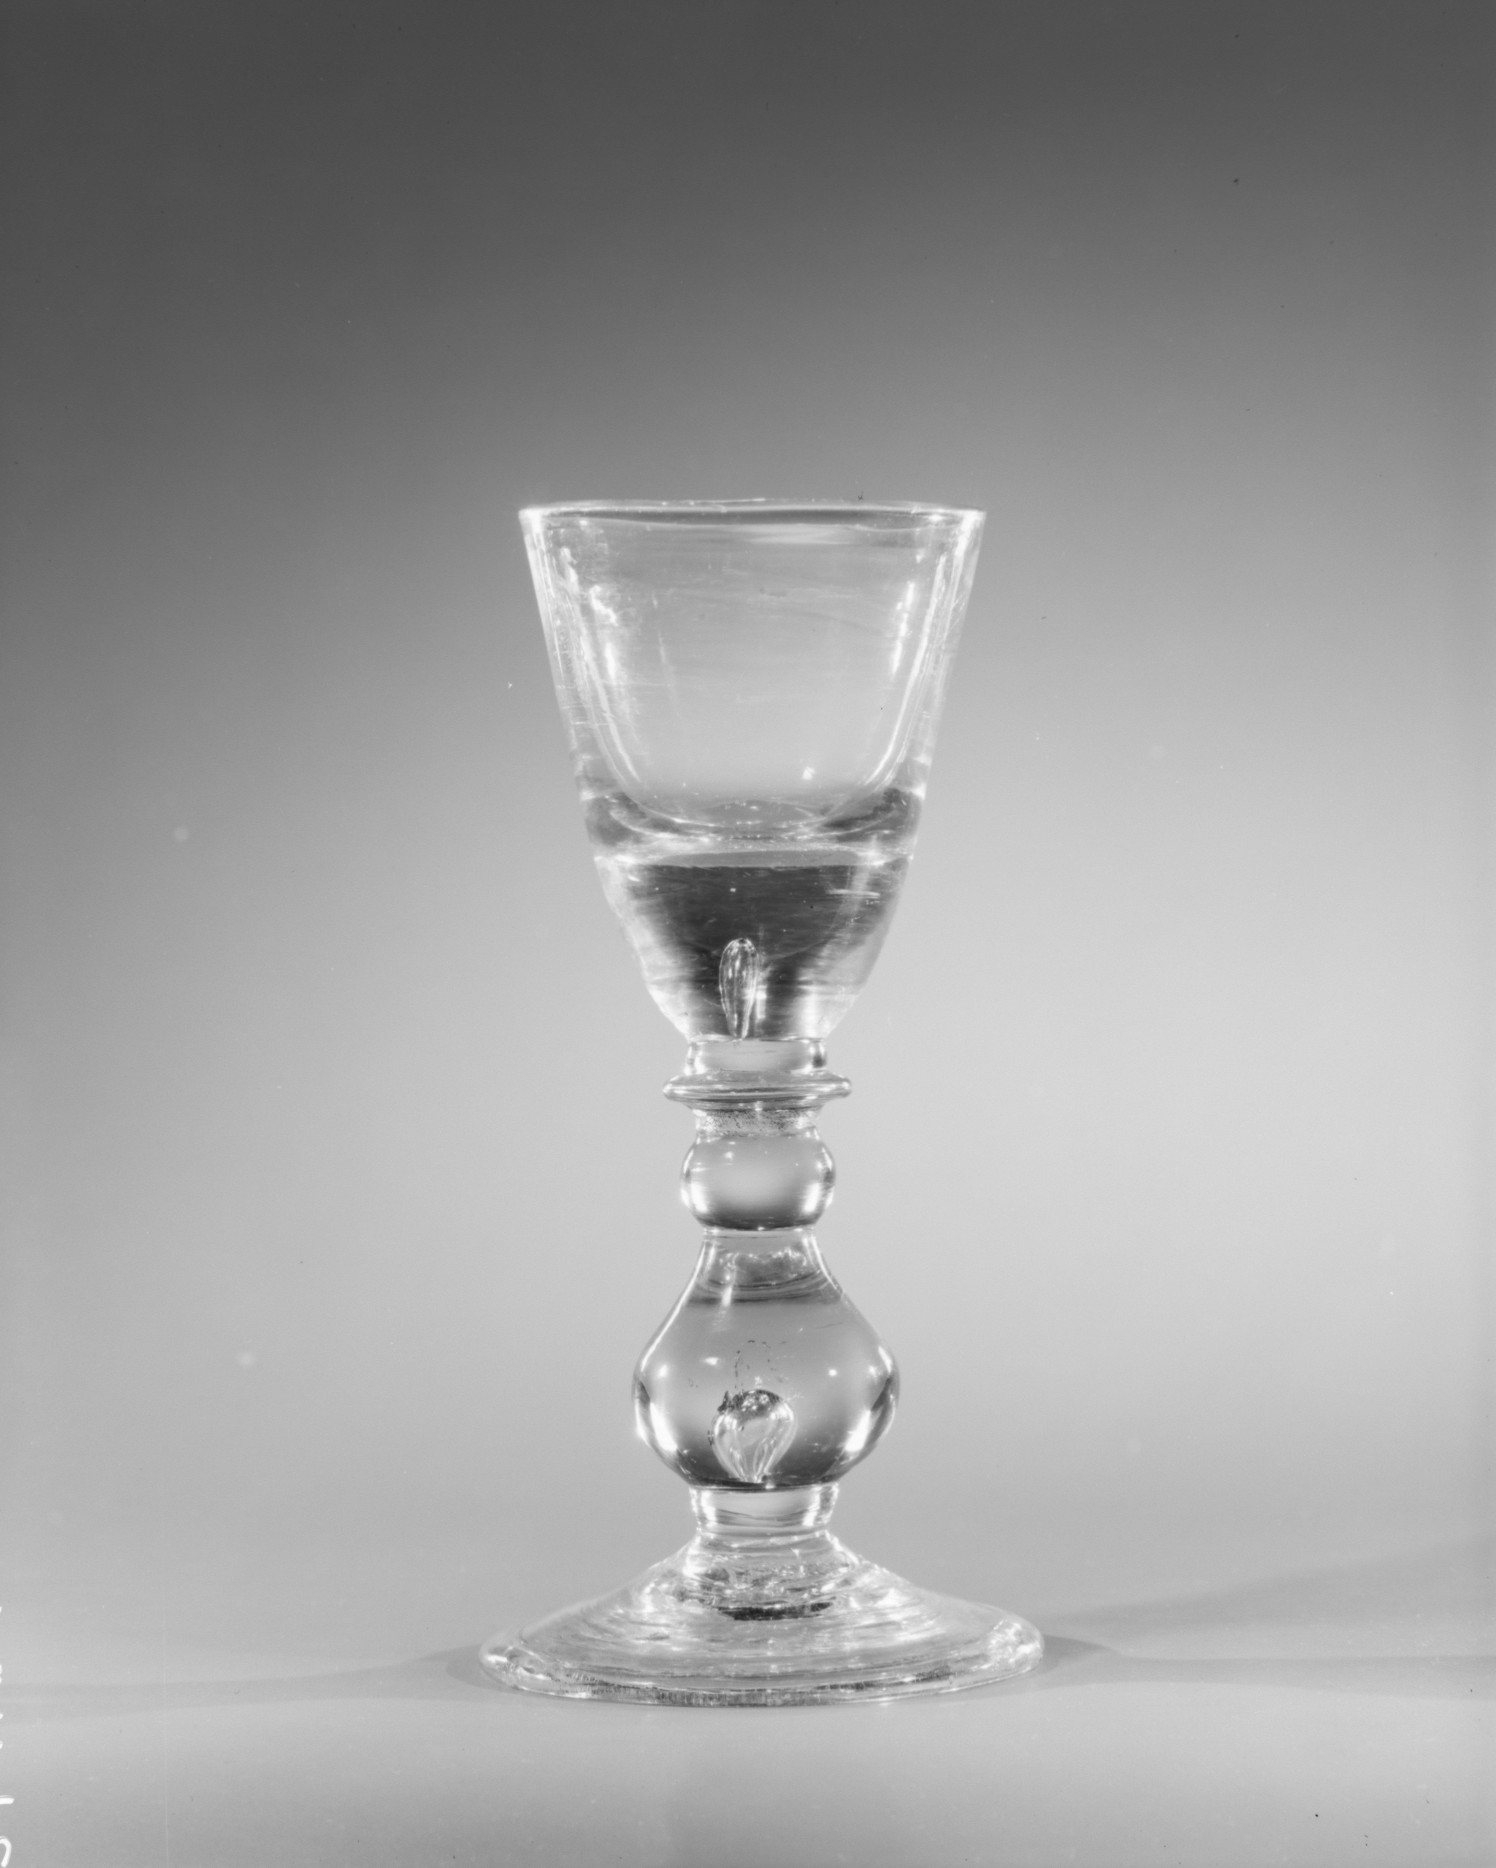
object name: wineglass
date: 1667-1733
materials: glass